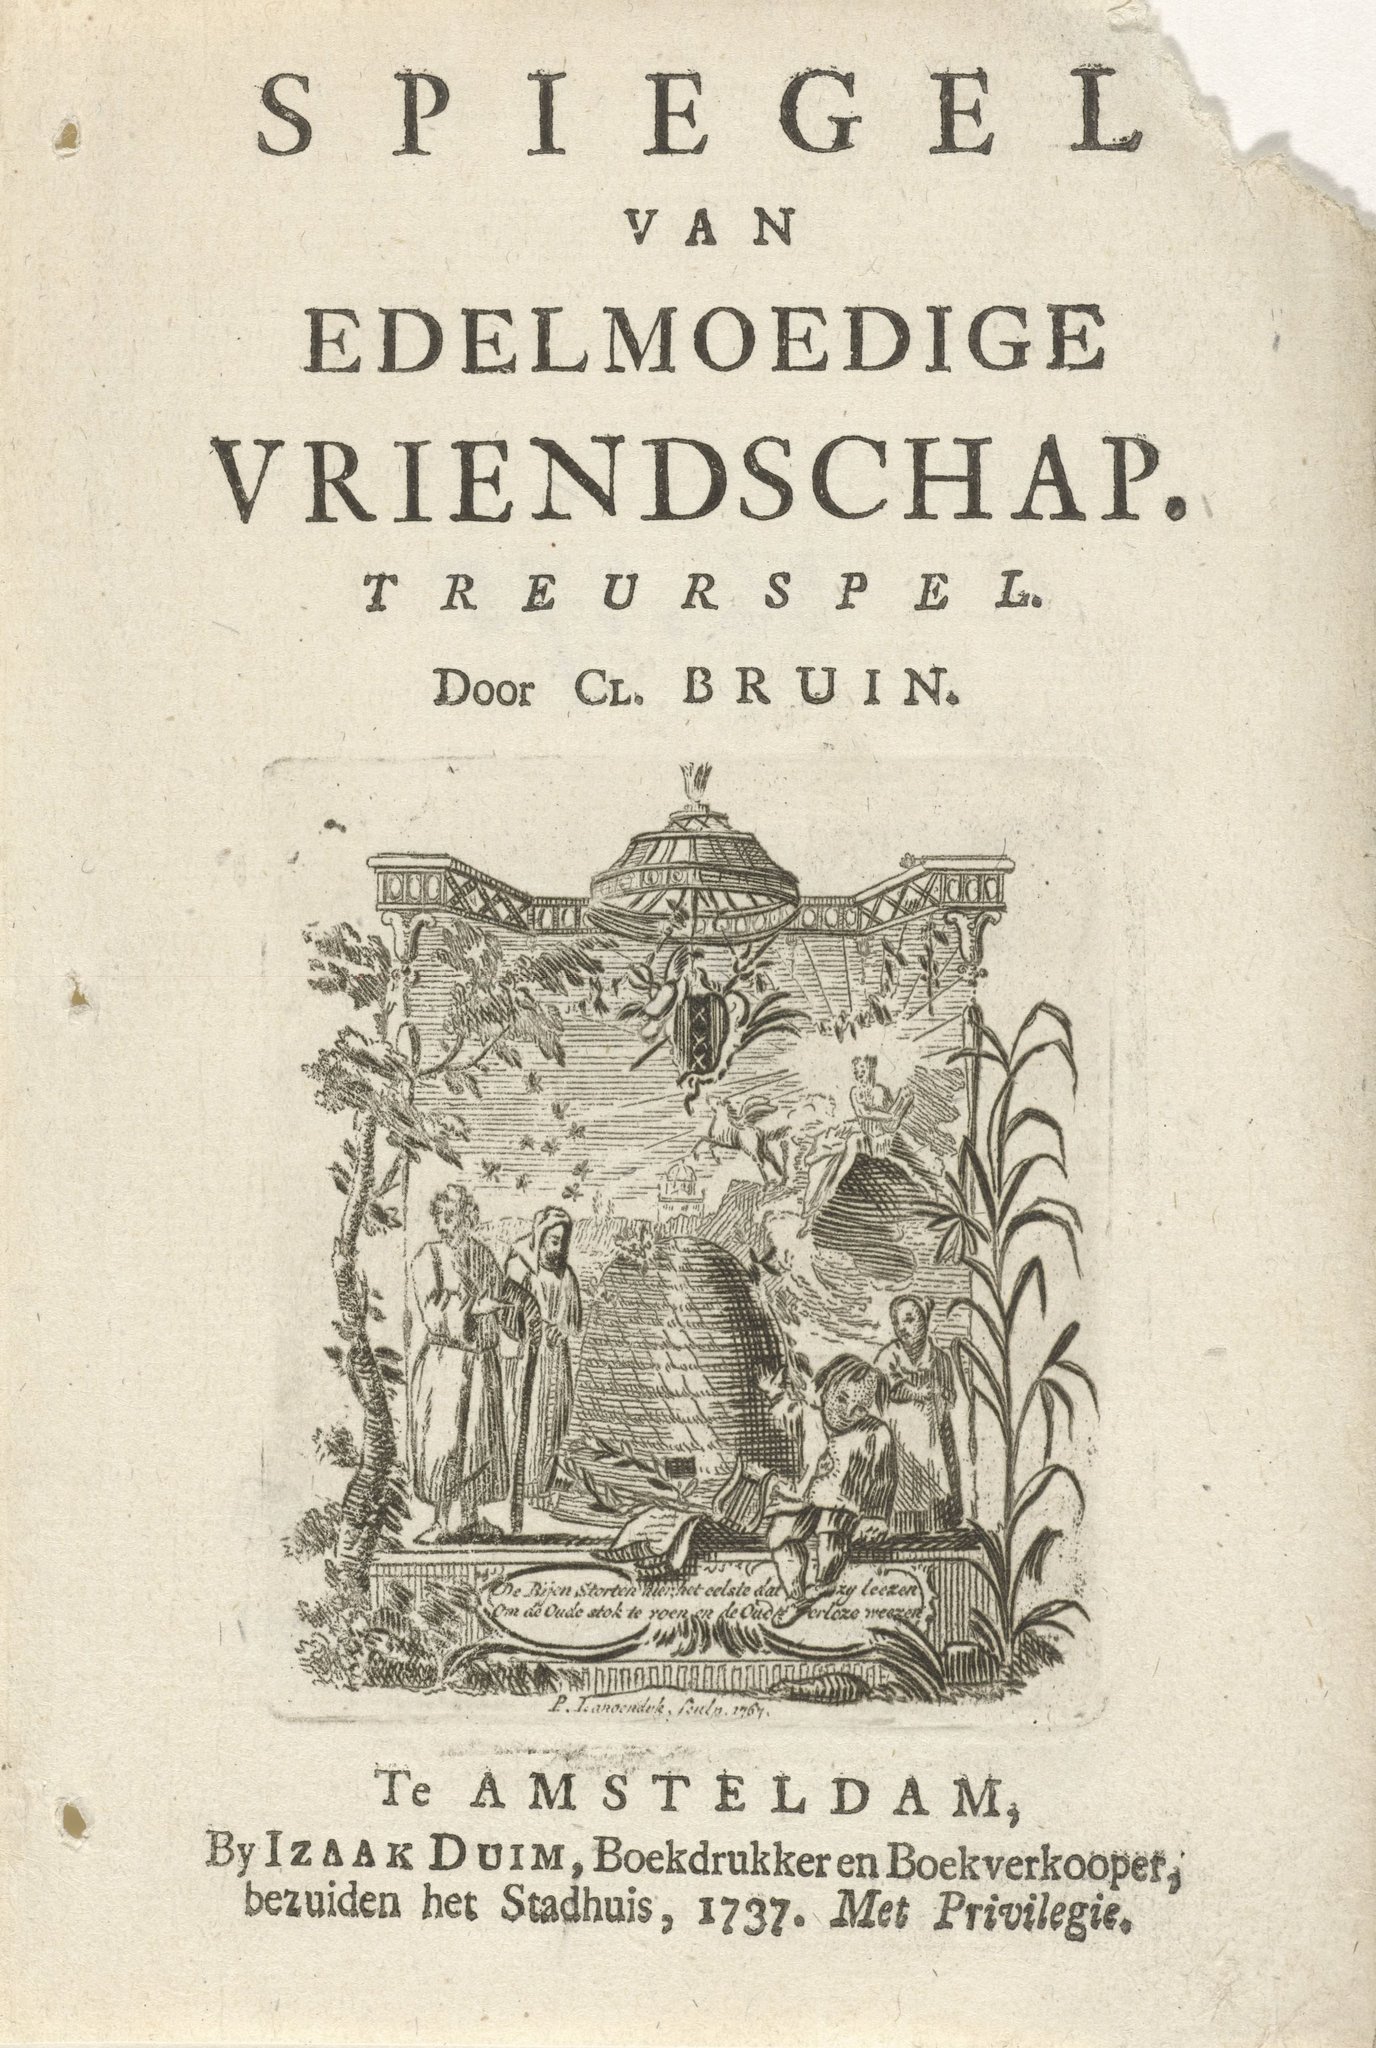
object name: print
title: Titelpagina voor: C. Bruin, Spiegel van edelmoedige vriendschap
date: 1767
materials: paper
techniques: letterpress printing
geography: amsterdam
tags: coat of arms (as symbol of the state, etc.) (+ city; municipal), pegasus, the winged horse, bee-hive, apollo playing the lyre, apollo citharoedus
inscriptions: collector's mark: Lugt 2760, collector's mark: Lugt 2228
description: Op een toneel staan figuren rond een bijenkorf, symbool van de Amsterdamse schouwburg. Op de achtergrond vliegt het gevleugelde paard Pegasus en bespeelt Apollo op de berg Parnassus de lier. De voorstelling is omlijst met gebladerte en takken, bovenin prijkt het wapen van de stad Amsterdam. Op een rand onder de bijenkorf staat een tweeregelig vers in het Nederlands.